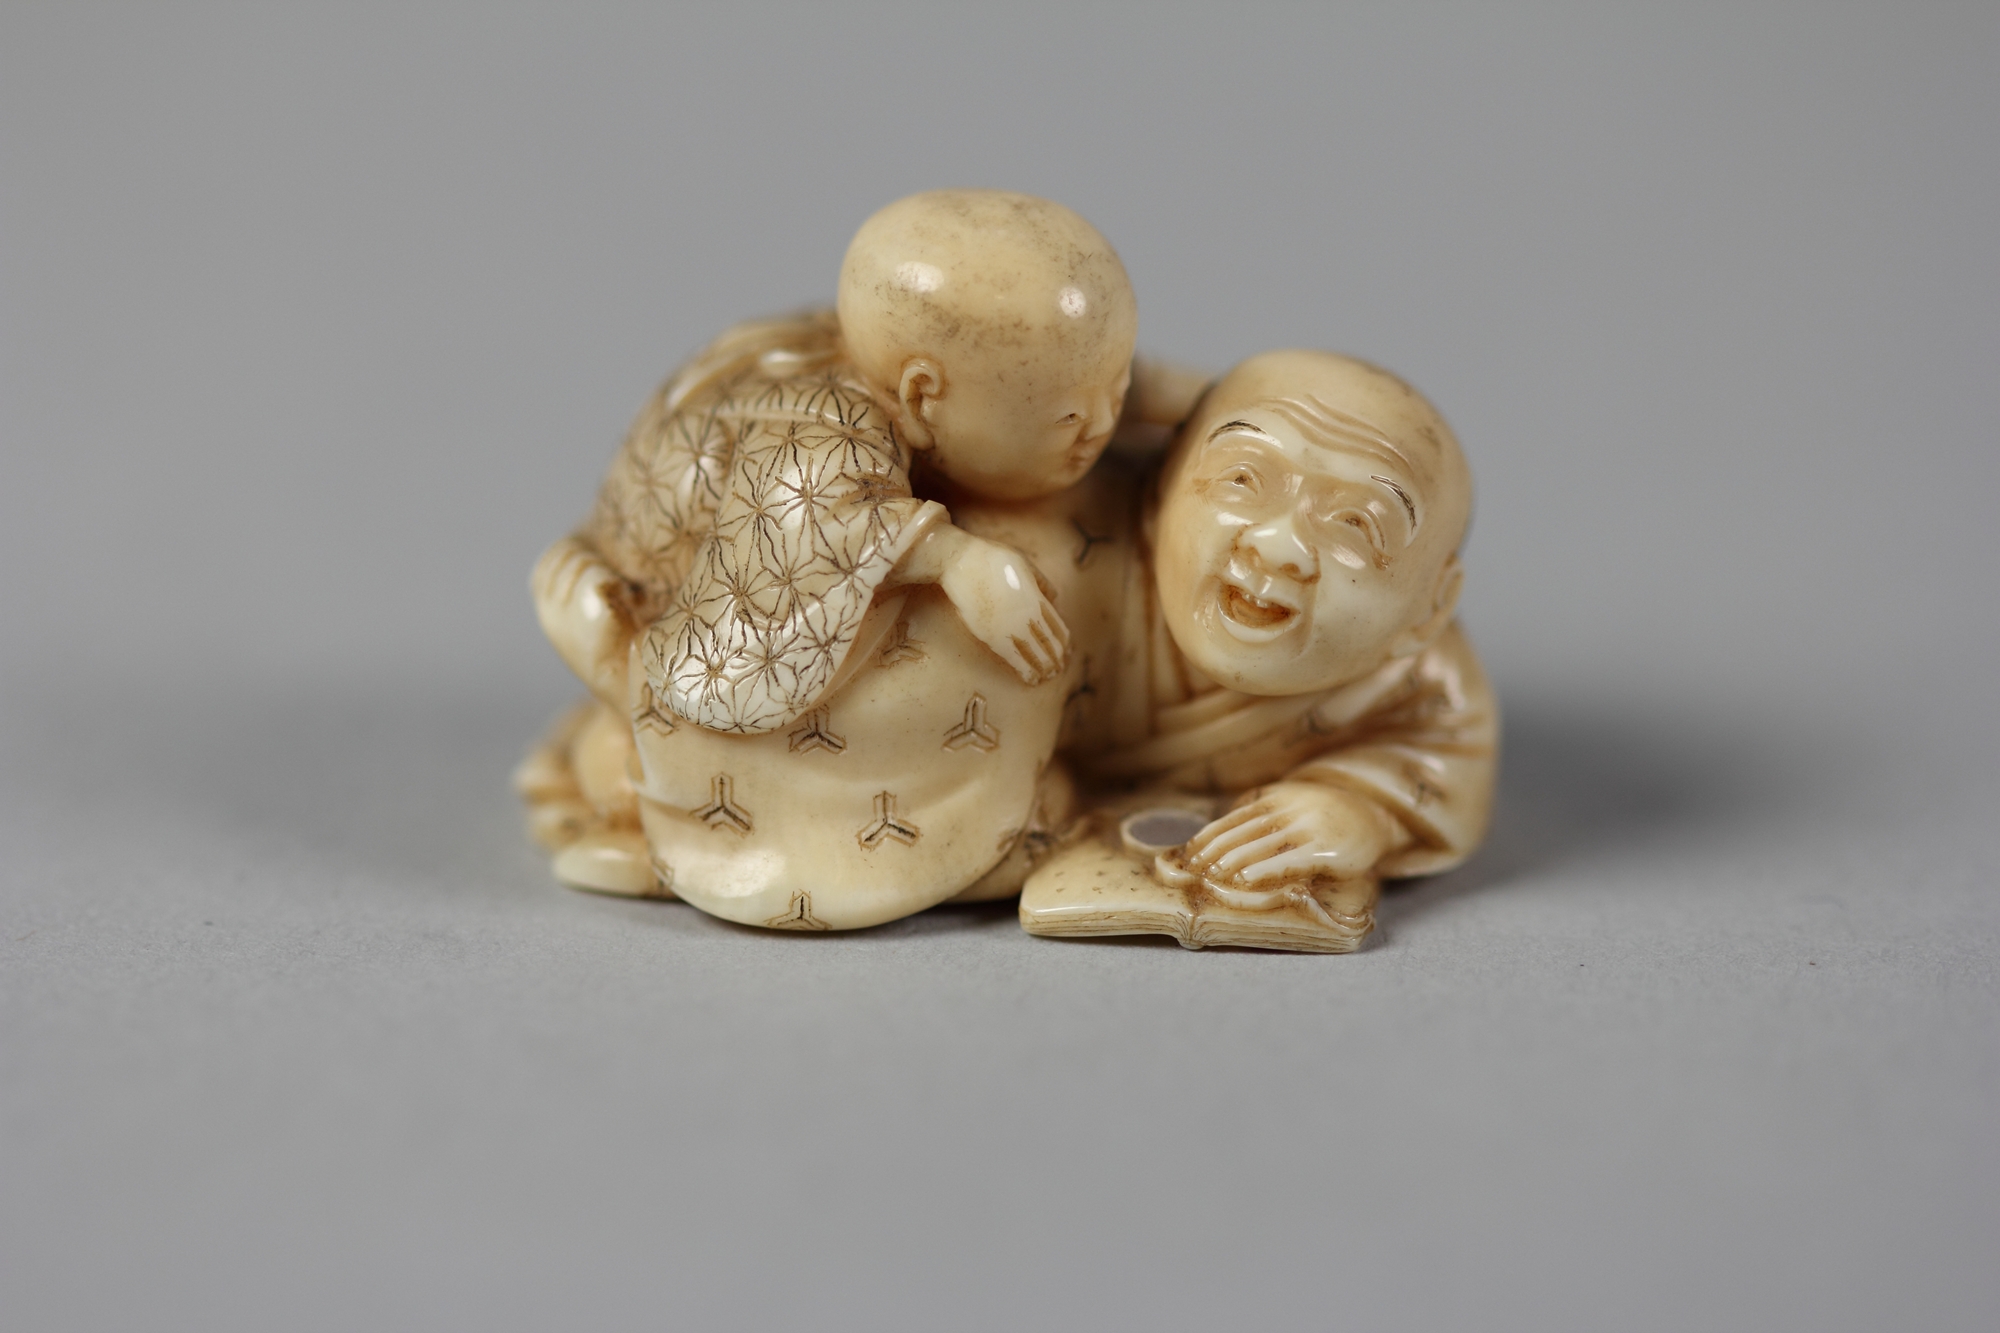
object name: netsuke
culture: japanese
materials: ivory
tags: men